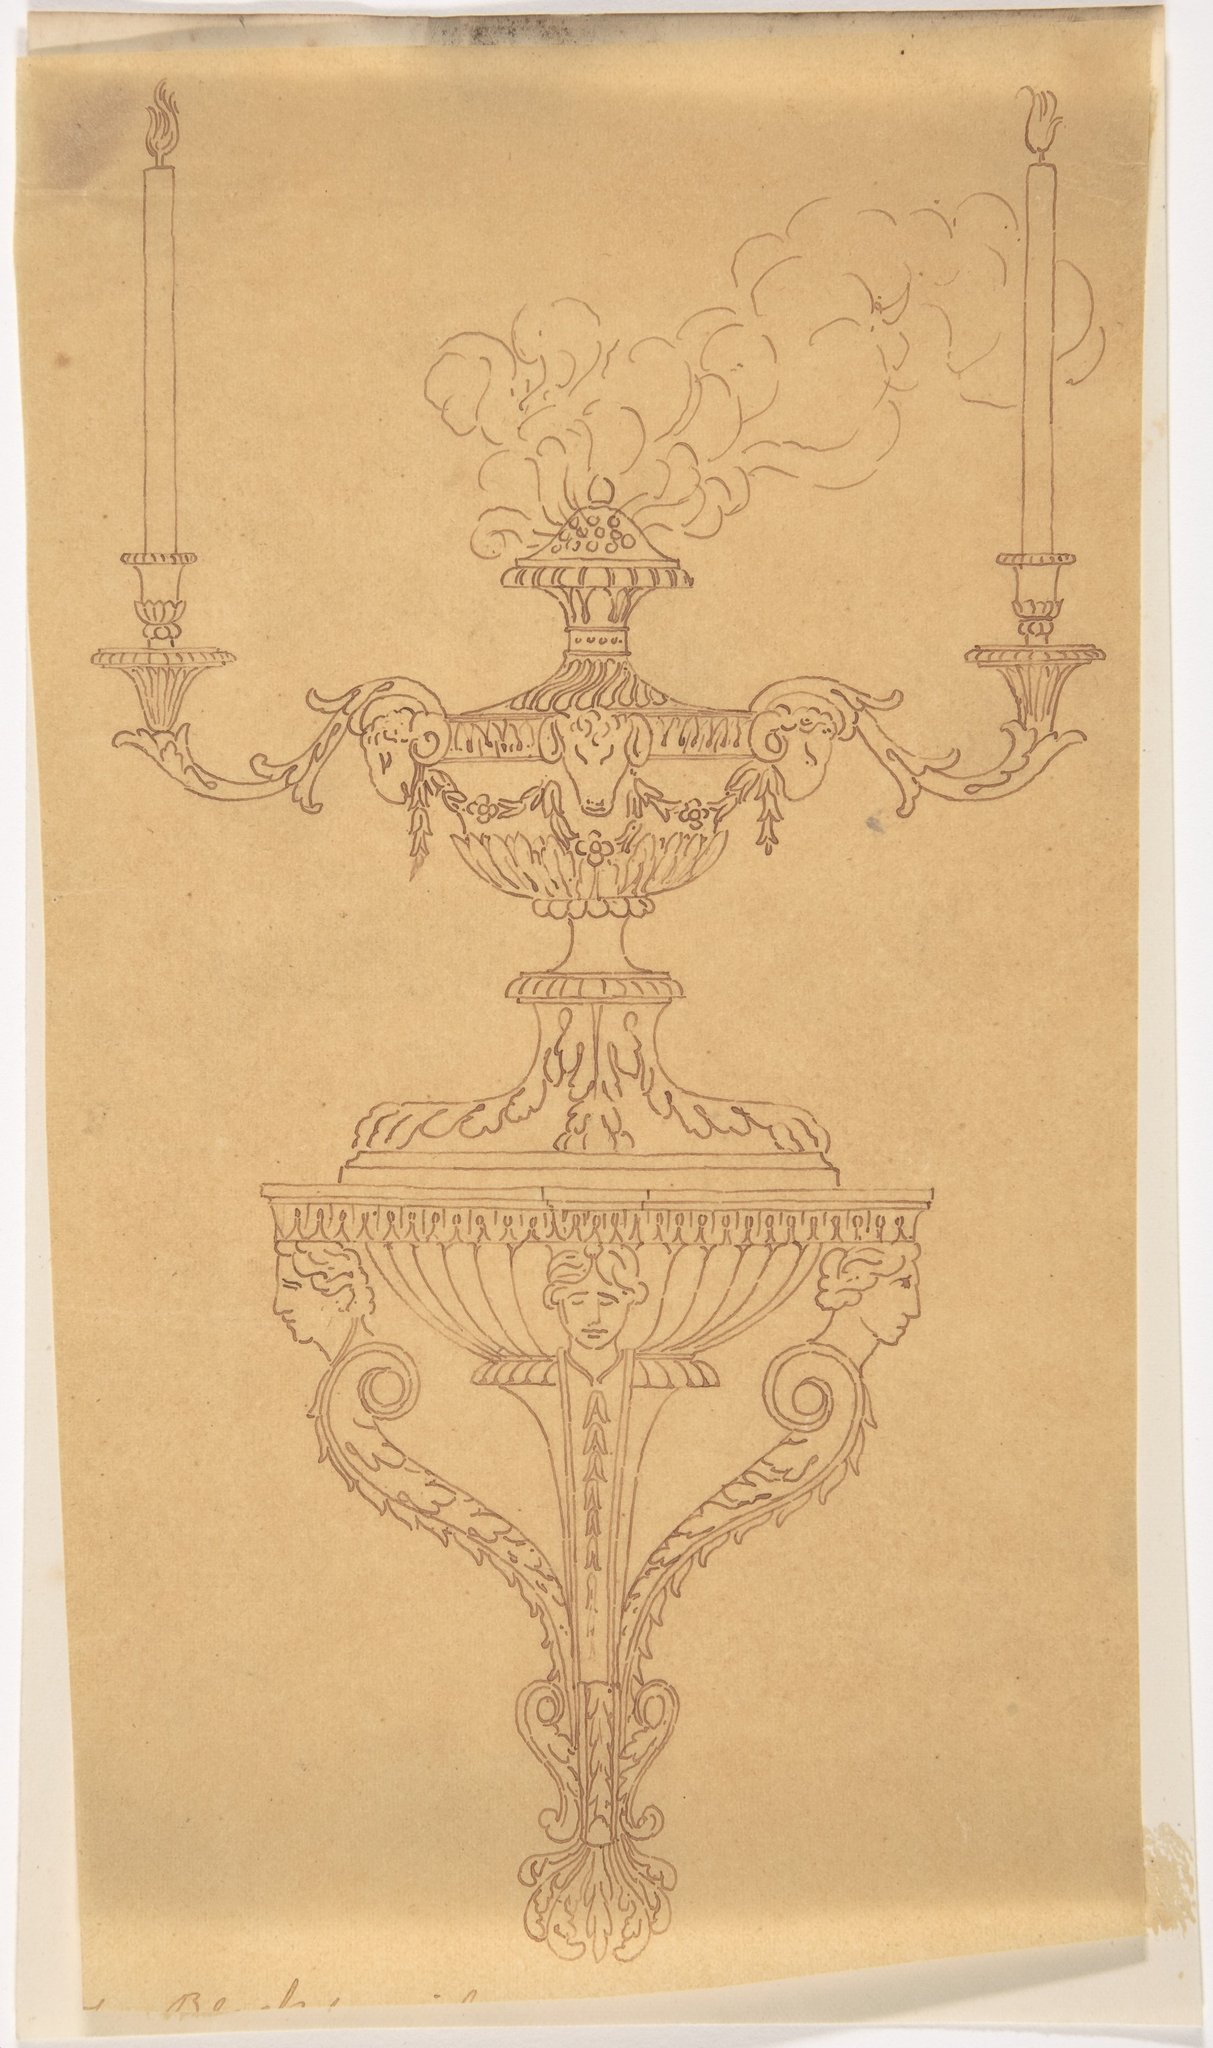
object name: drawing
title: Classical Incense Burner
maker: anonymous, british, 19th century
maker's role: artist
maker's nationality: british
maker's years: 1800-1900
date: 1801-1900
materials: ink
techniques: pen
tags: incense burners